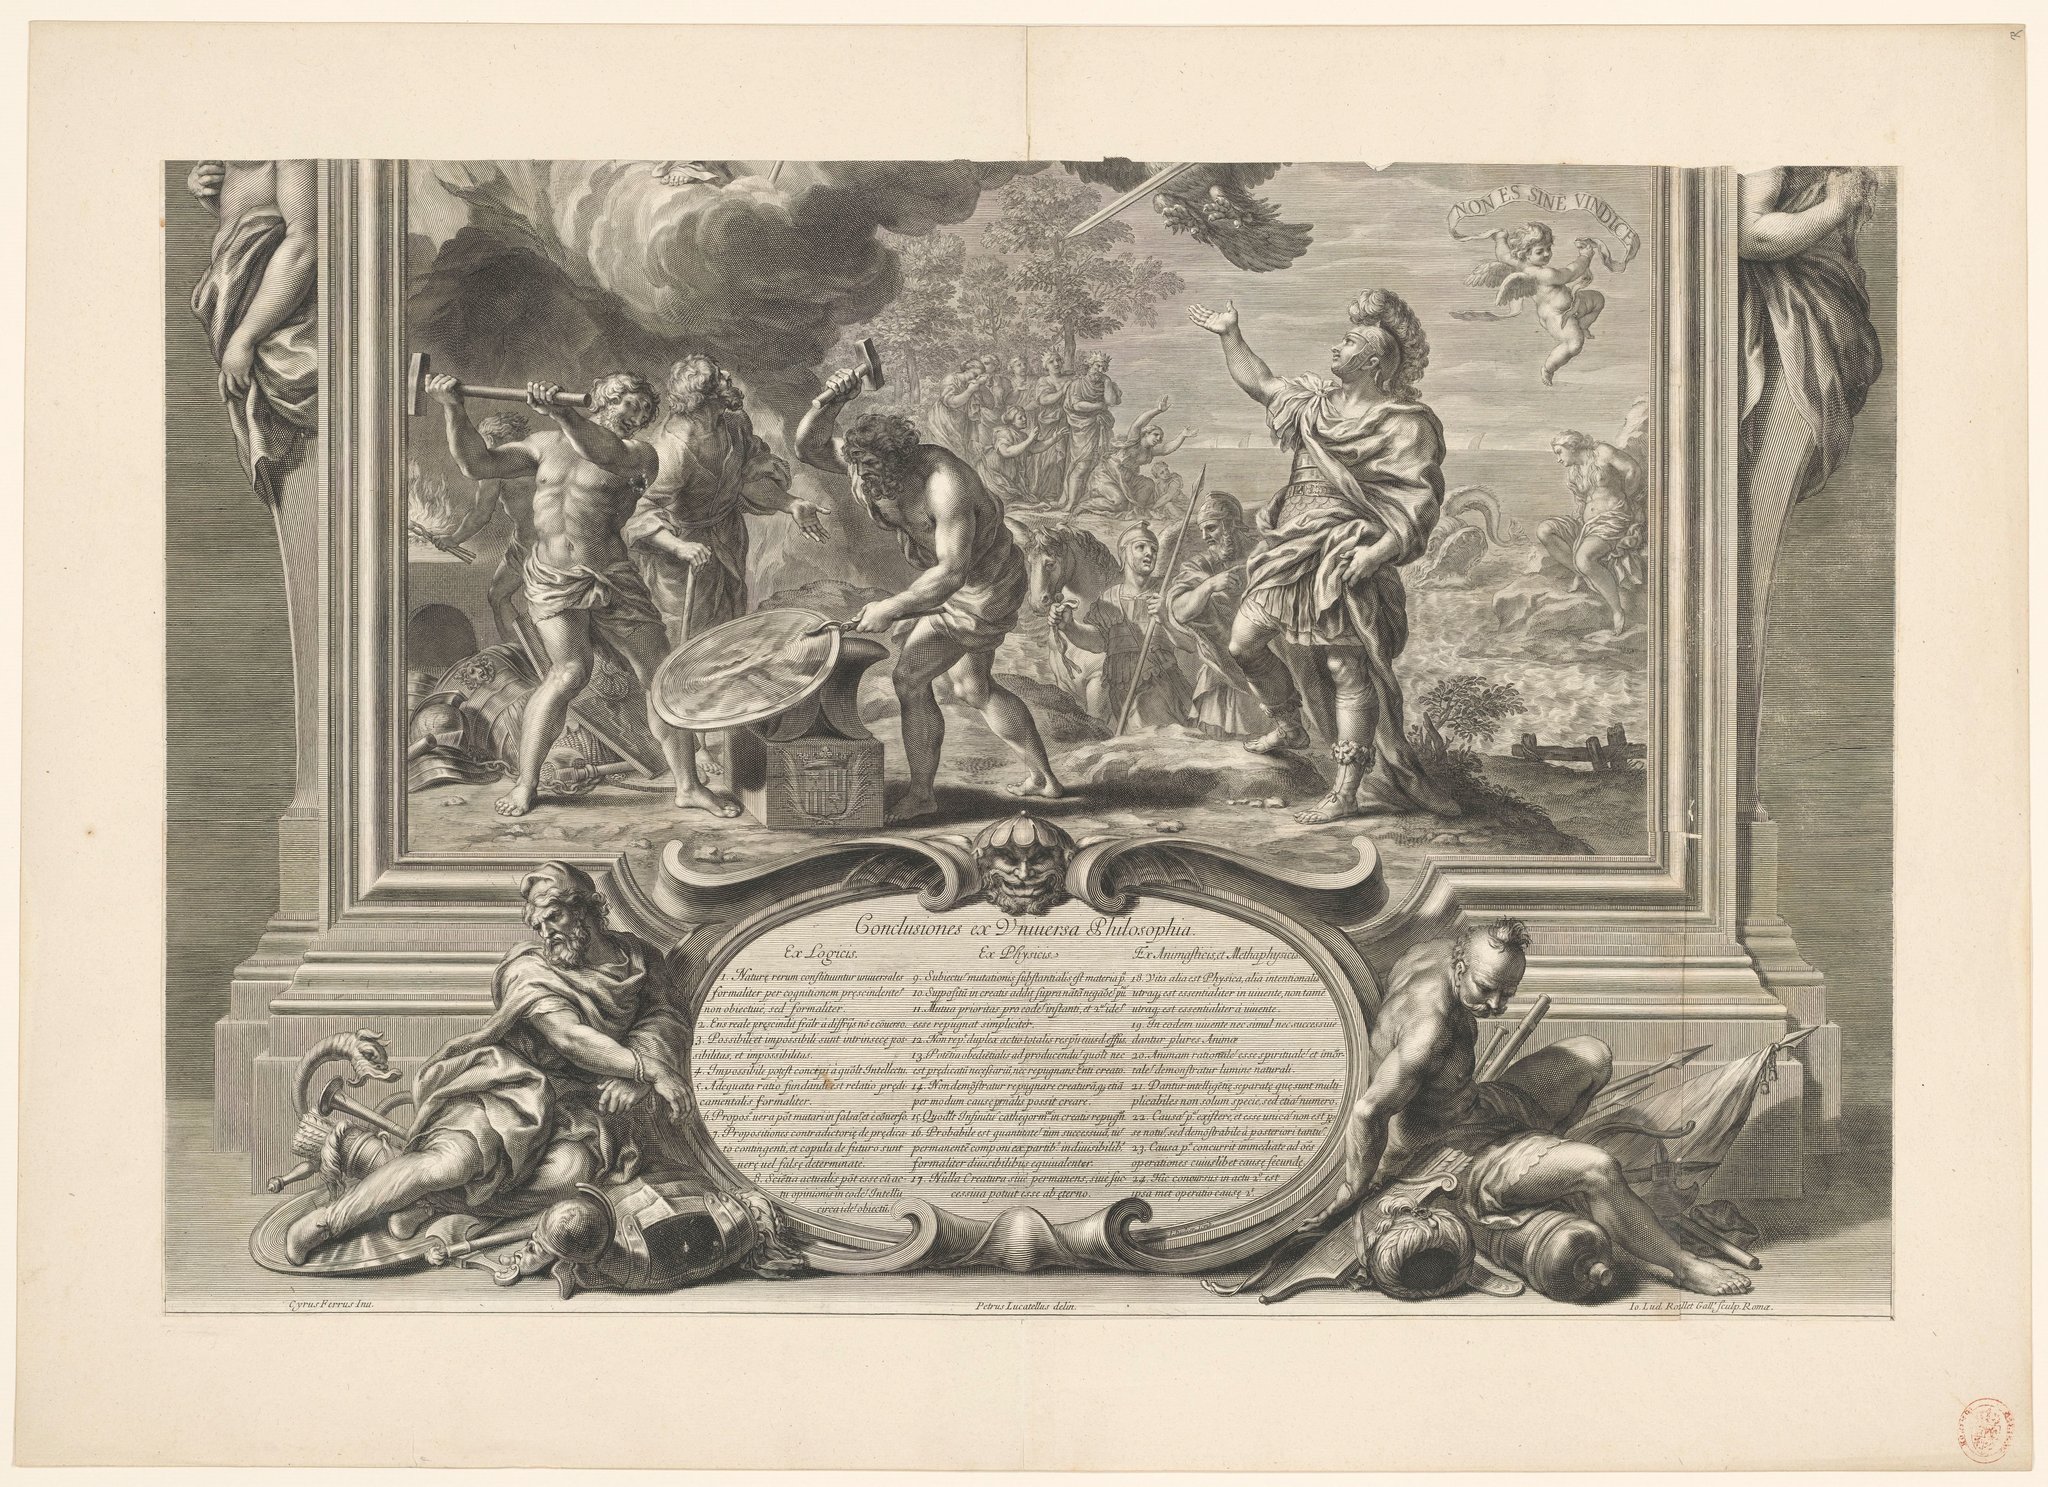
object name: promotieprent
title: Jupiter laat het schild van Theseus smeden door de cyclopen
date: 1655-1699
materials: paper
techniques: engraving, snipping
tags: the cyclopes forging, andromeda chained to the rock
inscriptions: collector's mark: Lugt 240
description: Onderste helft van een promotieprent. Promotieprent opgedragen aan keizer Leopold I